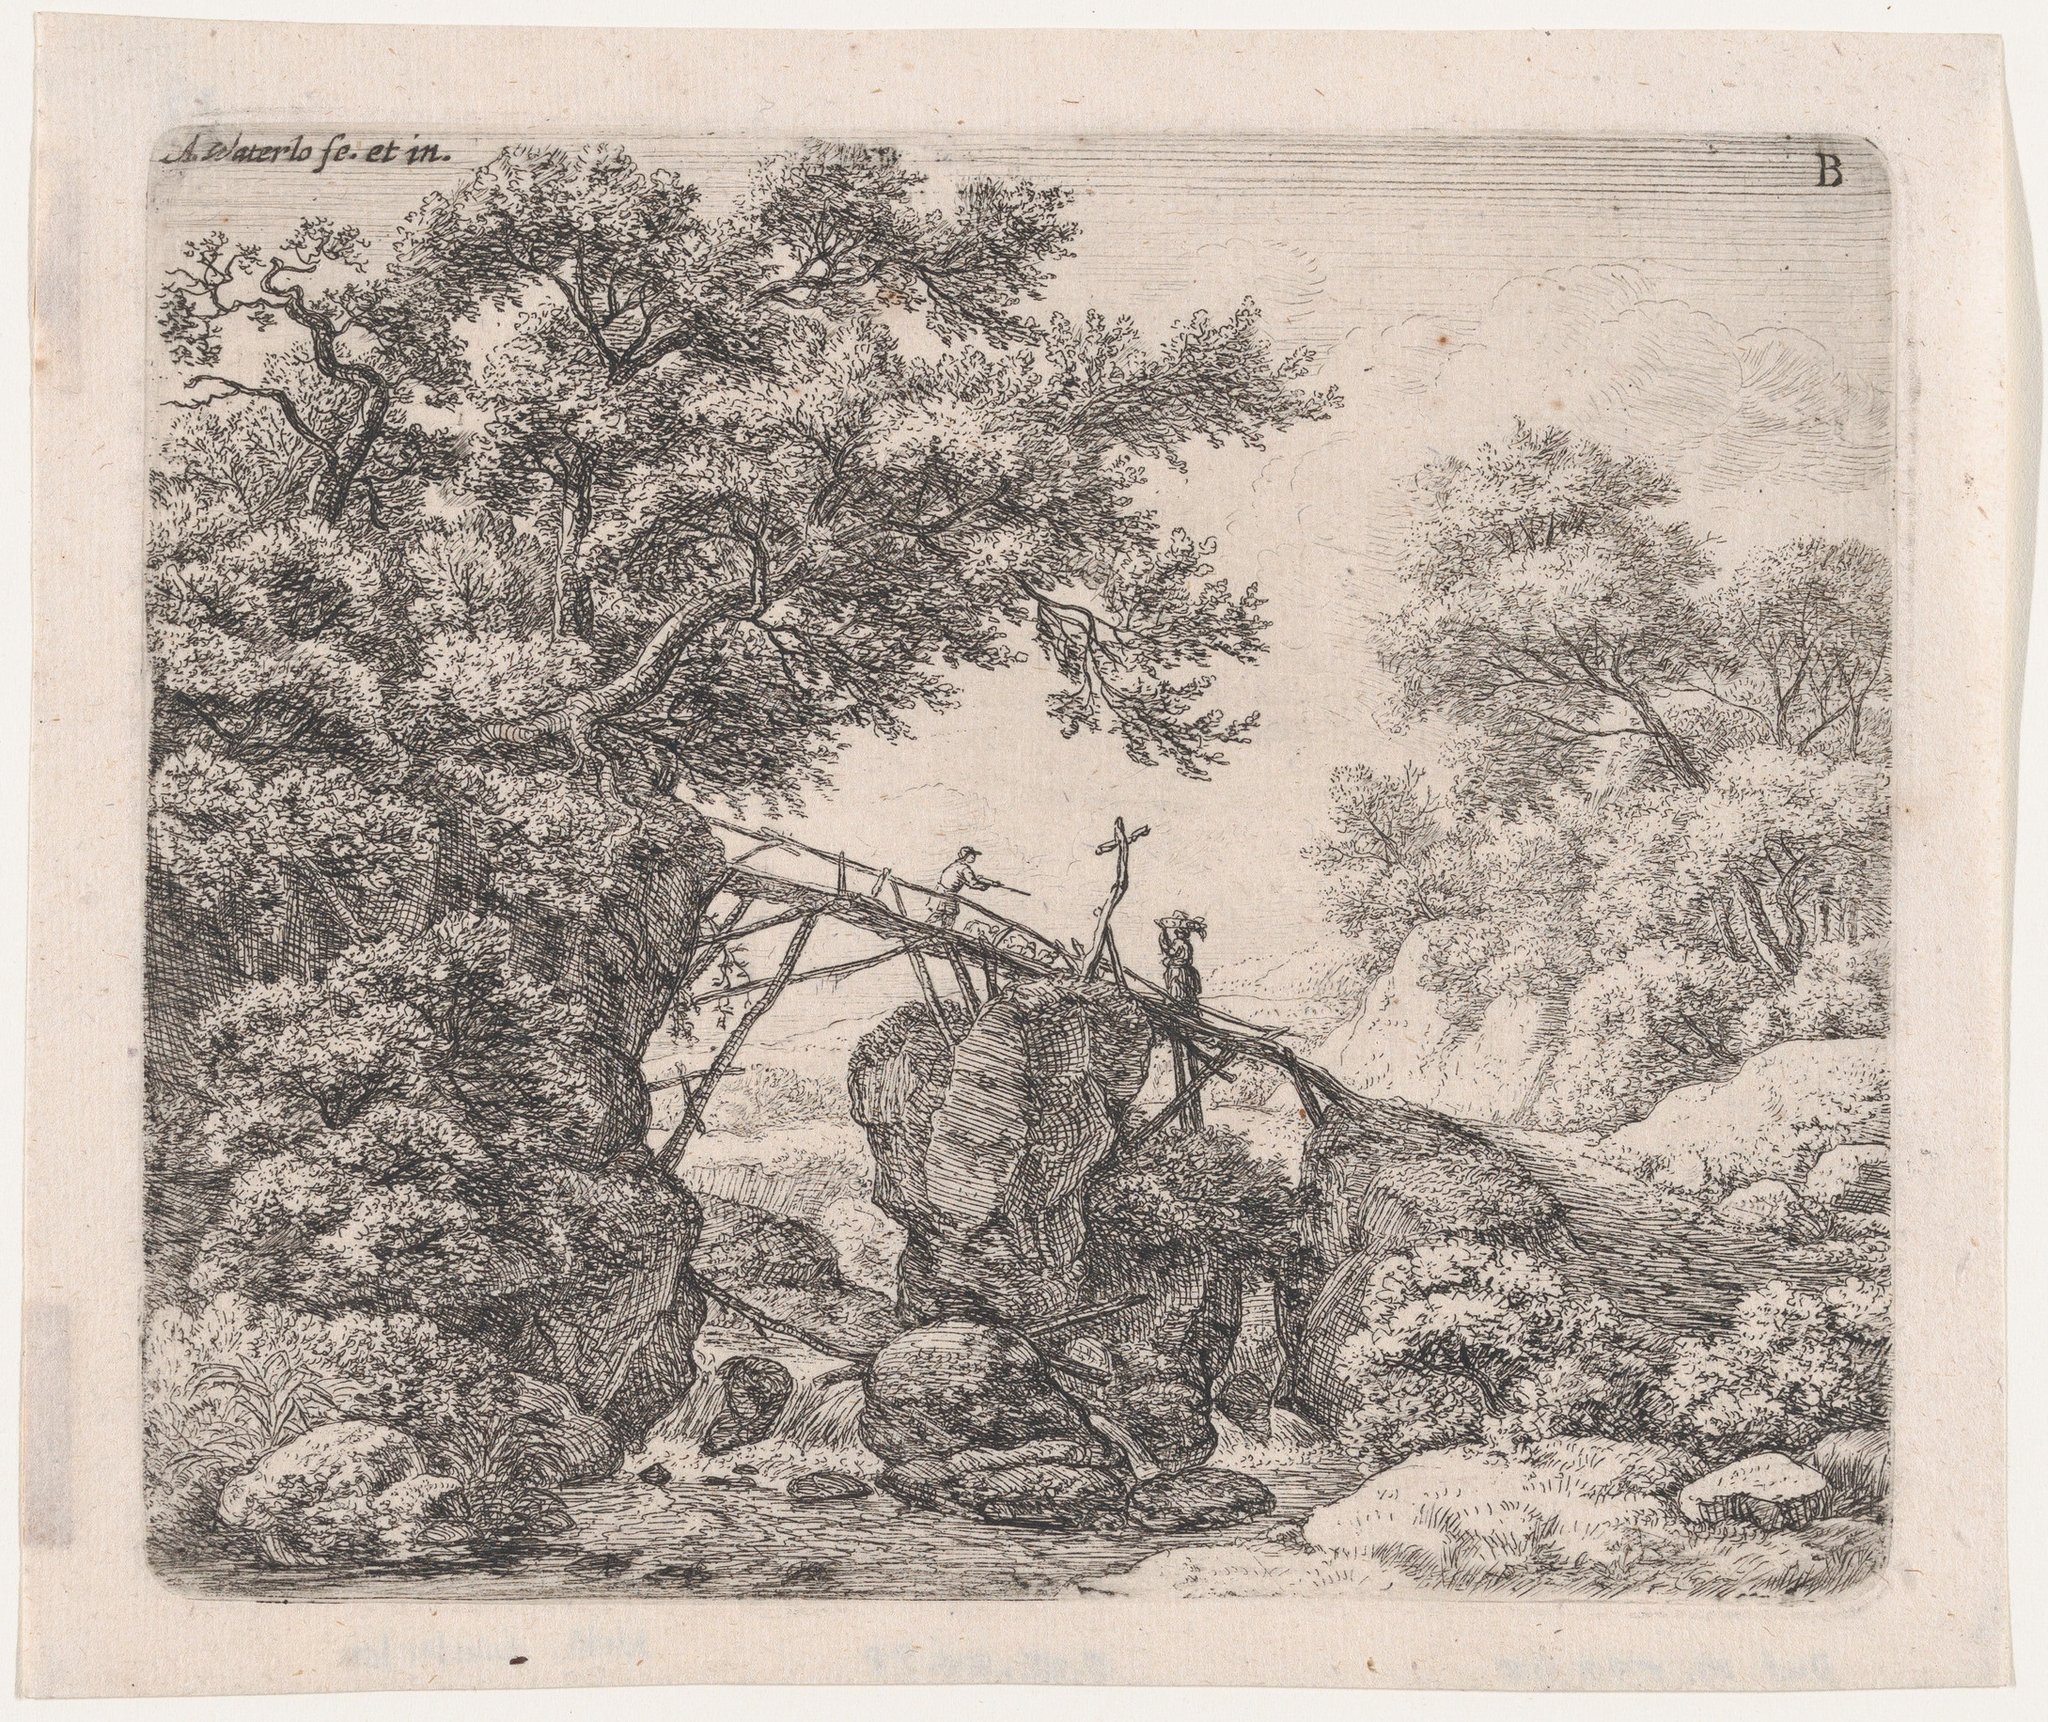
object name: print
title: A Small Sloping Bridge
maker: anthonie waterloo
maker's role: artist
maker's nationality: dutch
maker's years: 1609-1690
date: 1601-1700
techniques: etching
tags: human figures,bridges,trees